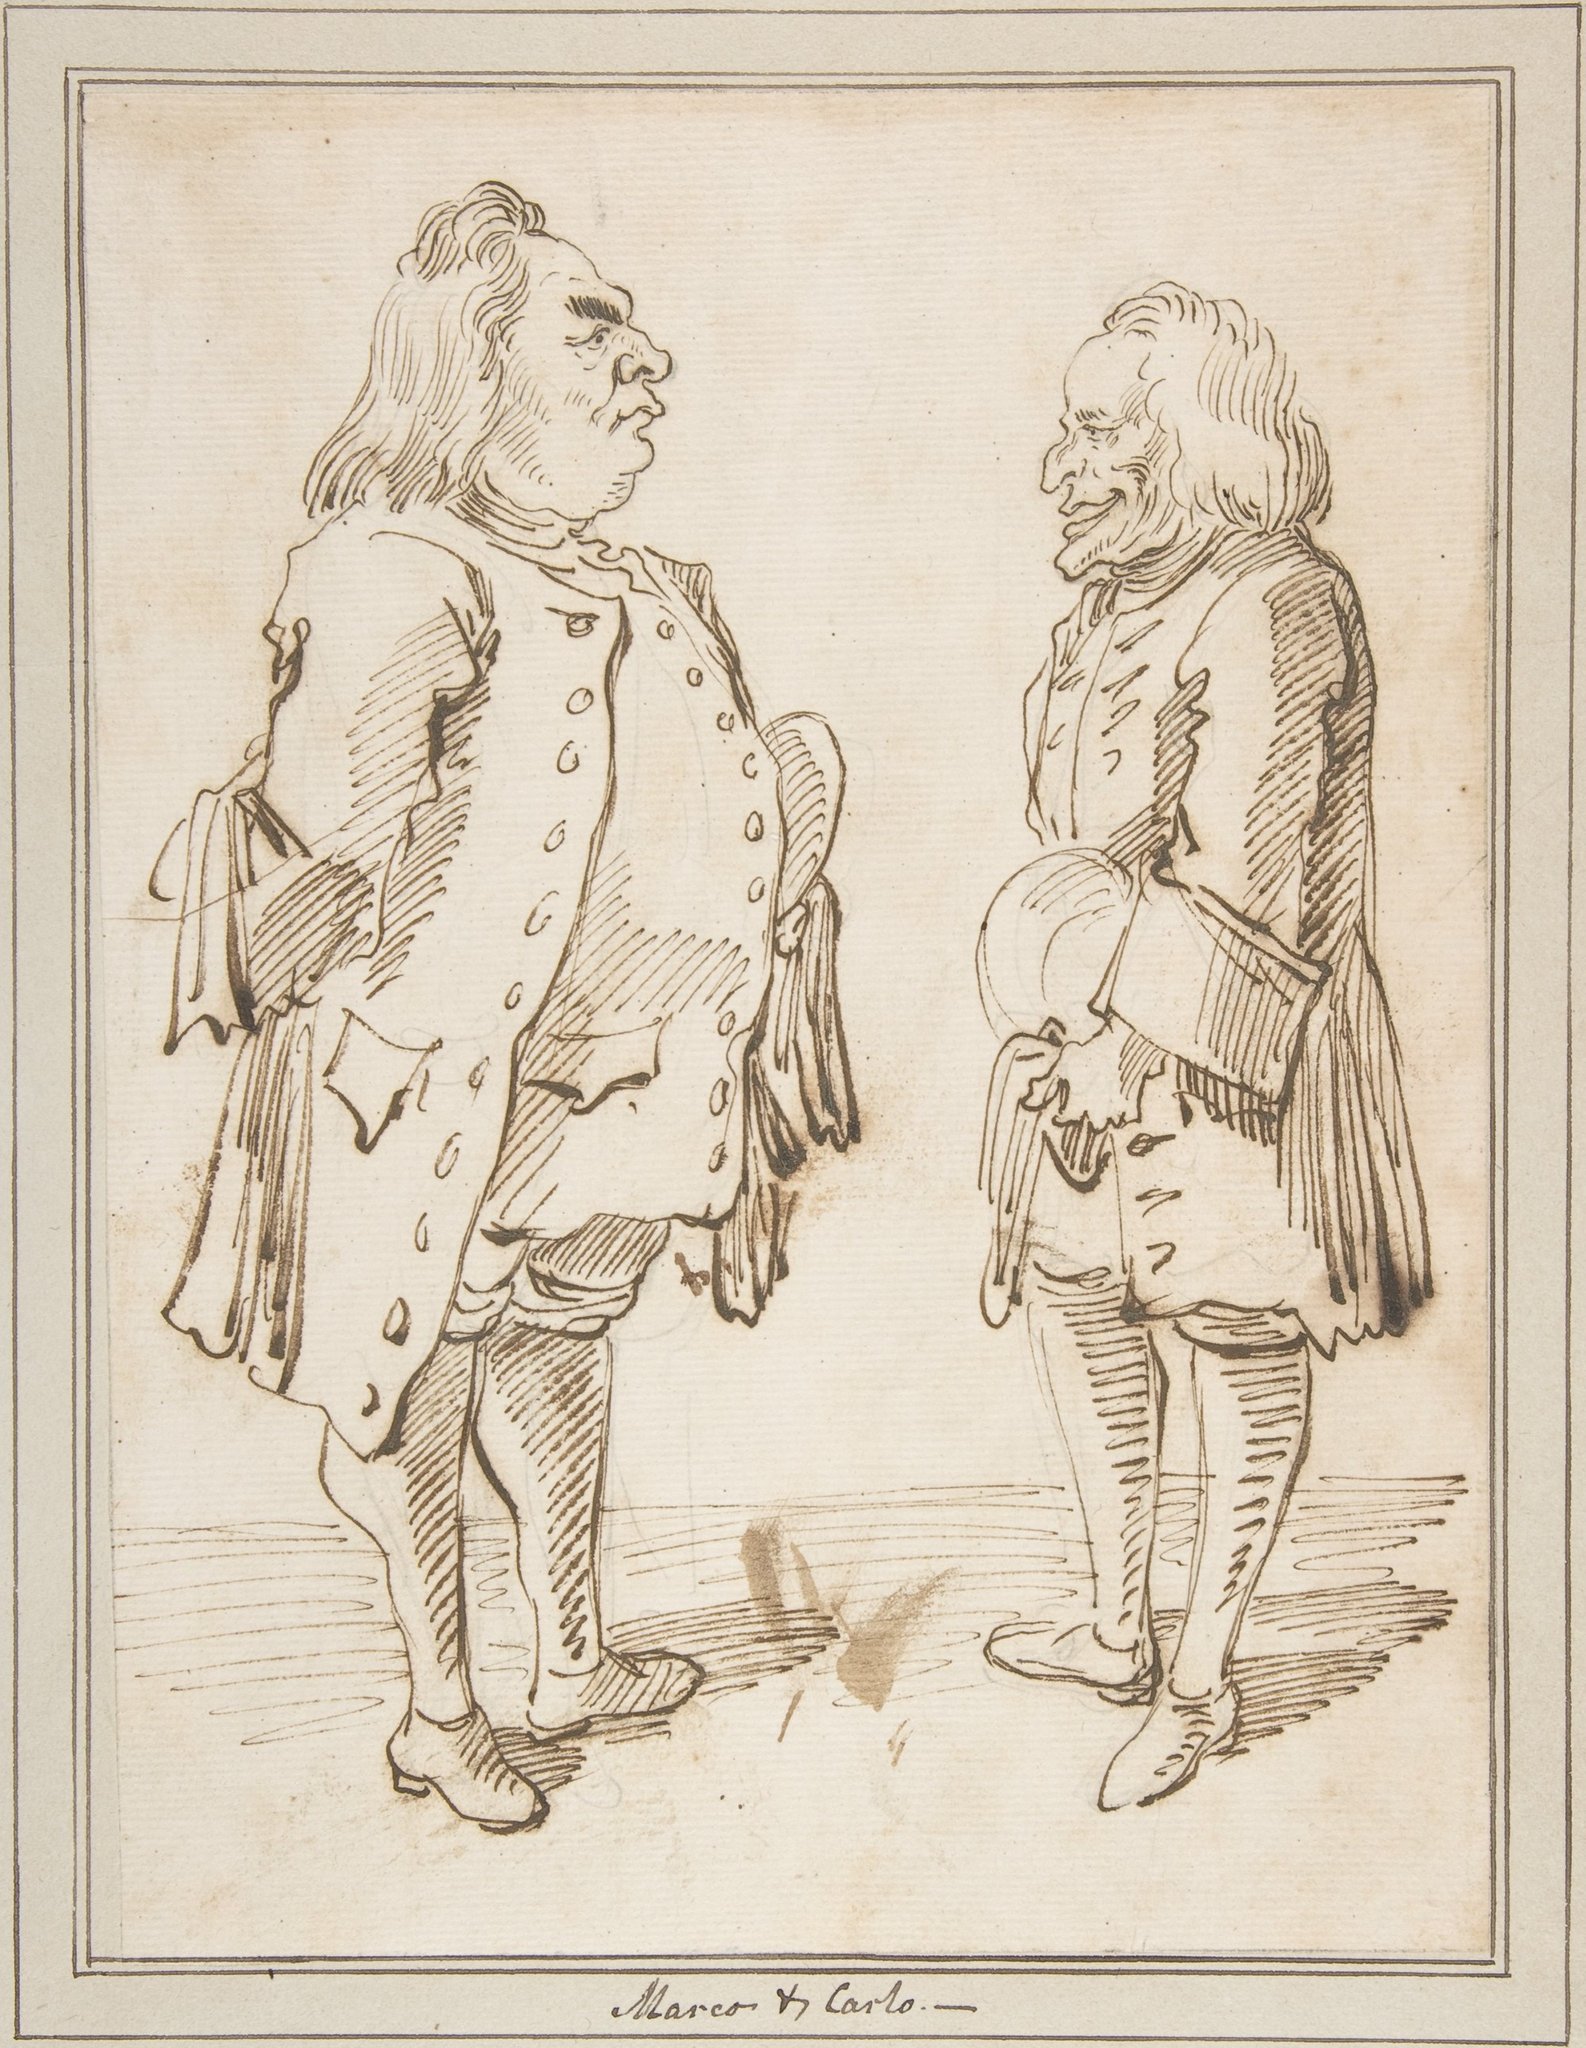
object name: drawing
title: Marco and Carlo: Caricature of Two Men Standing Face to Face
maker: pier leone ghezzi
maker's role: artist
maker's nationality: italian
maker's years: 1674-1755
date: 1674-1755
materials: graphite, ink, drawing material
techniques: pen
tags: satire